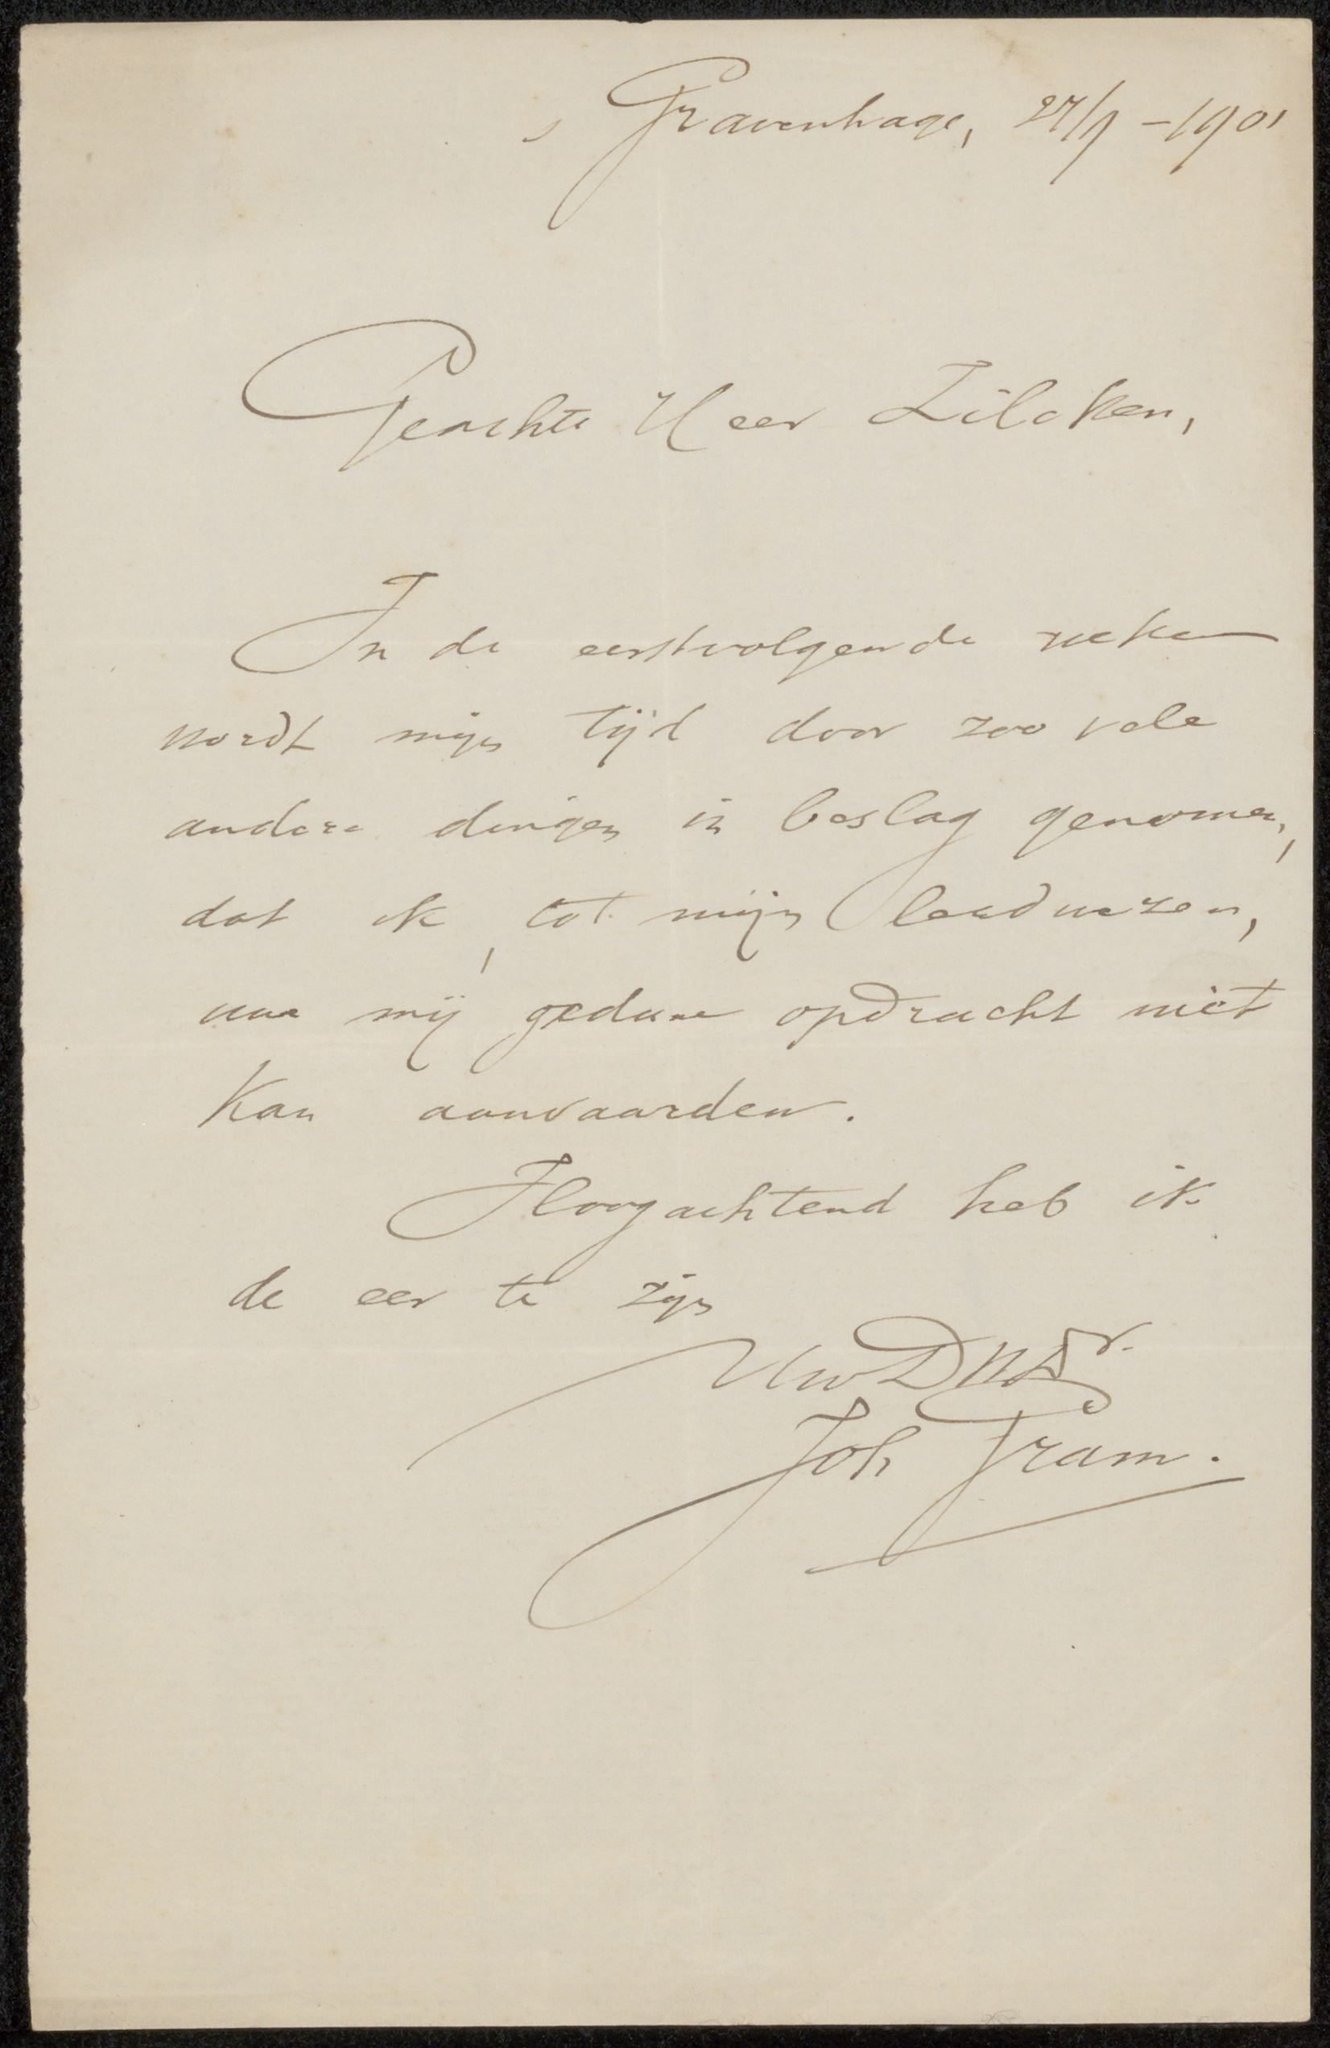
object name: letter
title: Brief aan Philip Zilcken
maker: johan gram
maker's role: kunstcriticus, letterkundige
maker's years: 1833-1914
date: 1901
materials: ink, paper, pencil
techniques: pen, writing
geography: the hague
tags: painter, draughtsman, philip zilcken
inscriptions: collector's mark: ‘RPK’